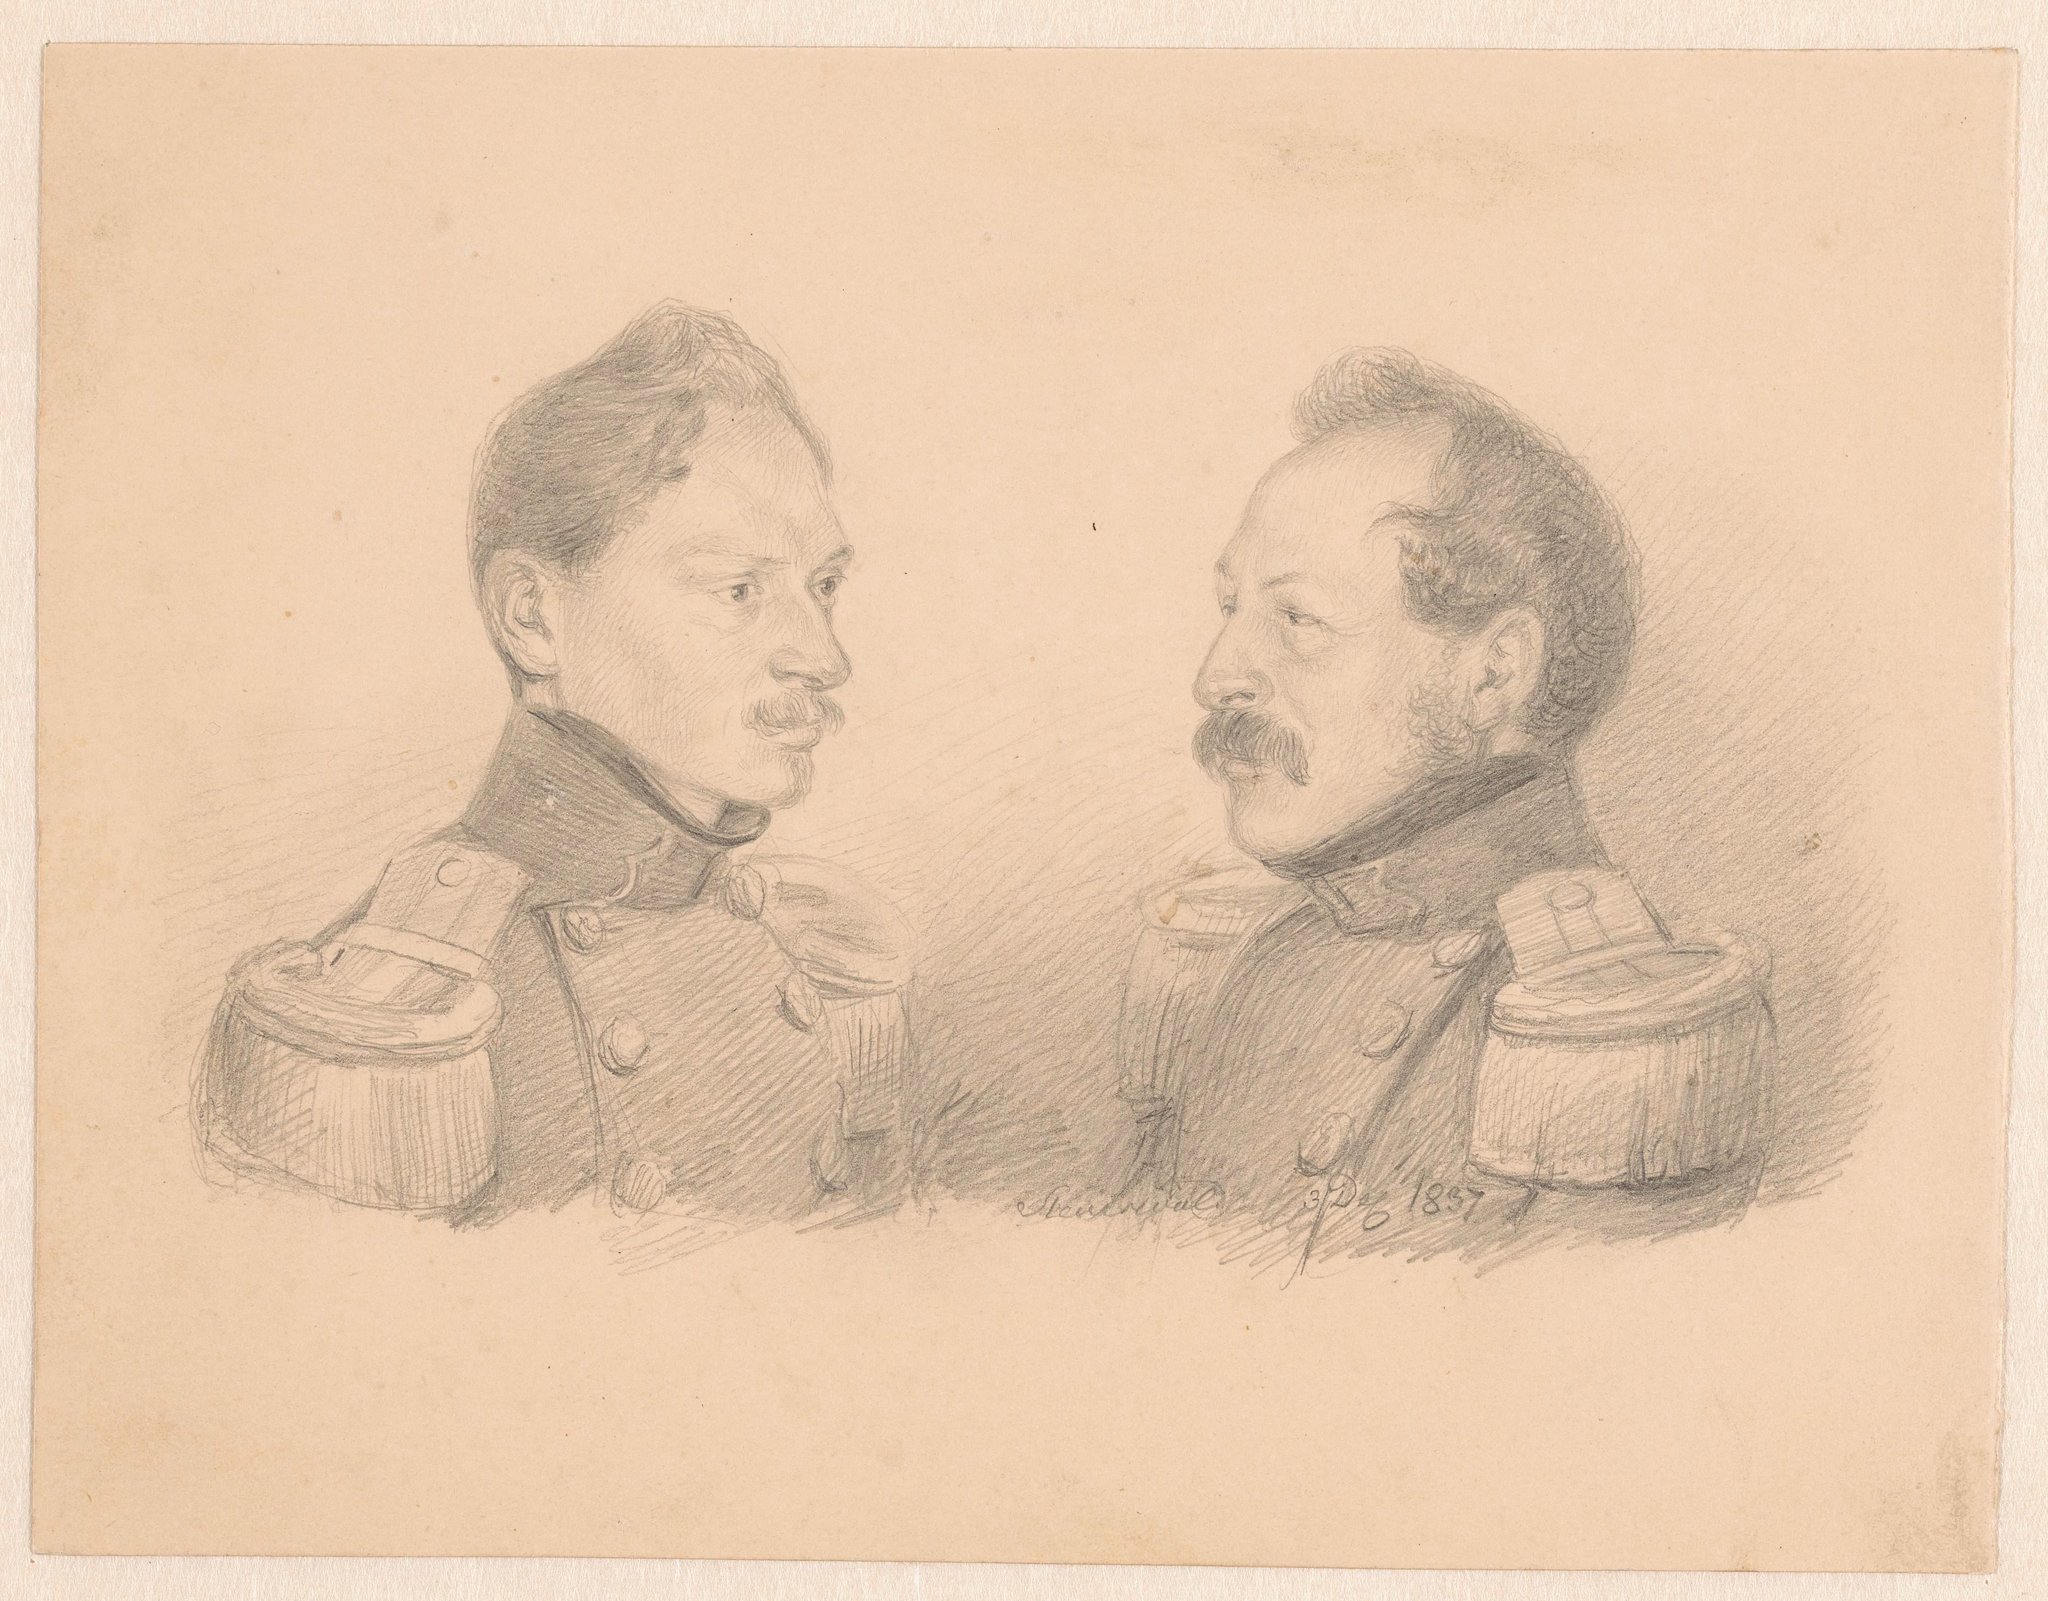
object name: drawing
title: Portret van twee militairen op een blad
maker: christian heinrich gottlieb steuerwald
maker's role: draughtsman, print maker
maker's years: 1802-1874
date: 1837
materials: paper, pencil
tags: anonymous historical persons portrayed in a double portrait